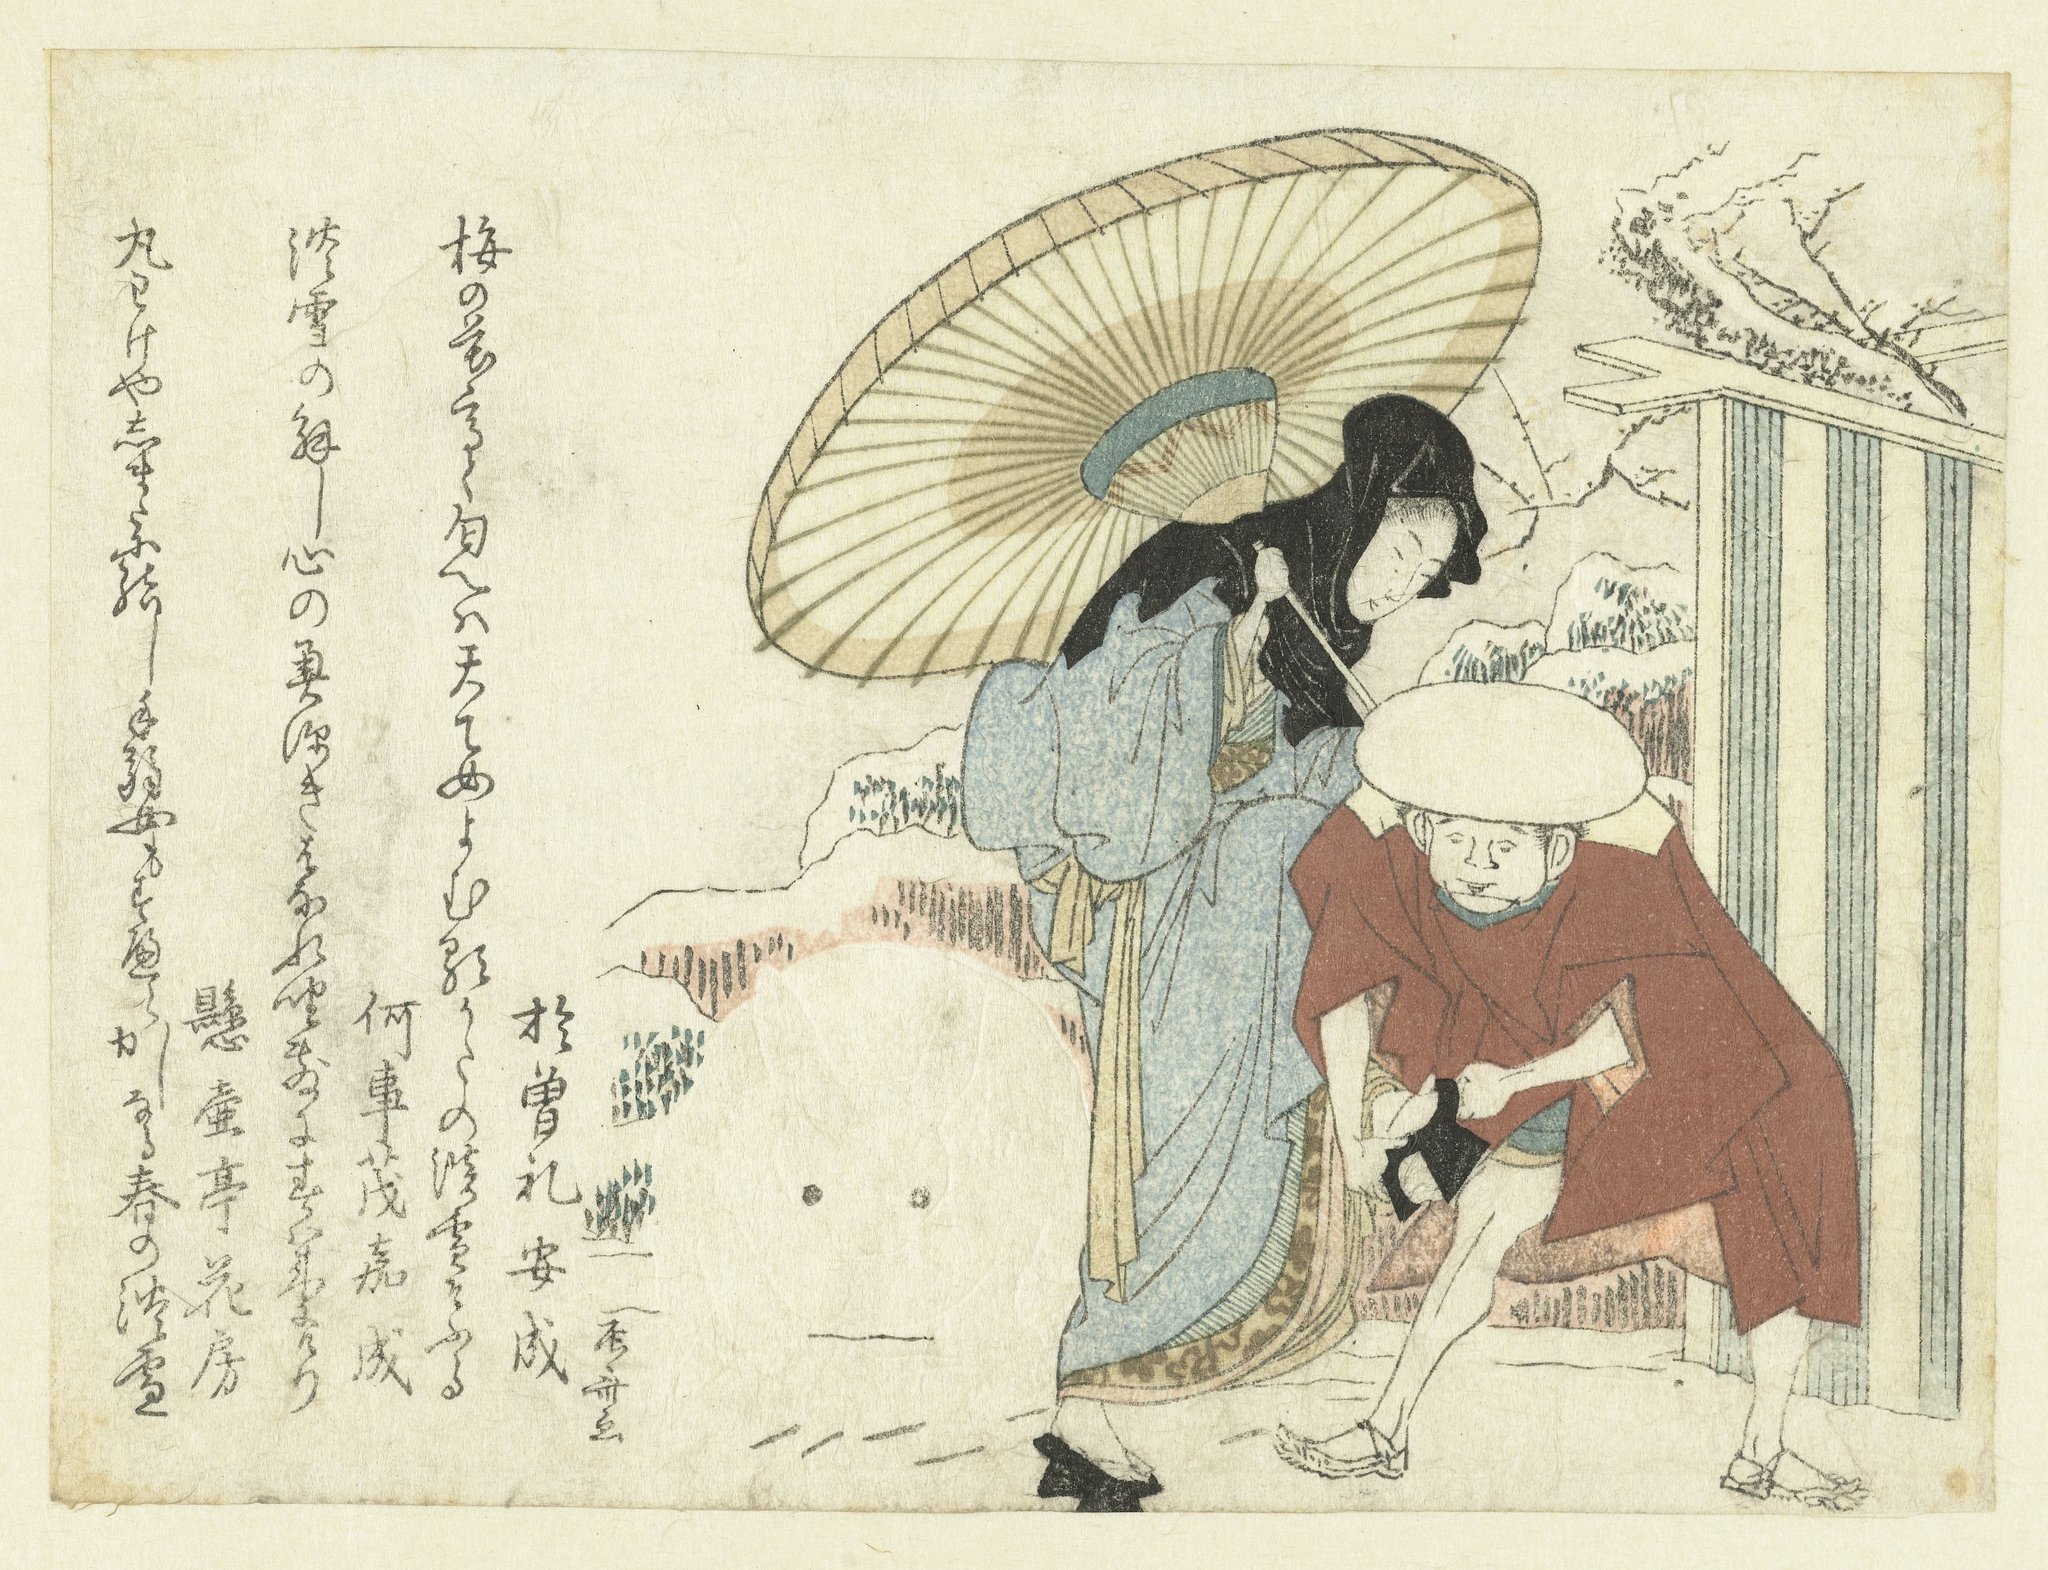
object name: surimono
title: Removing Clogged Snow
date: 1807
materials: paper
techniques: blind stamped, woodcut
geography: japan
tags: snow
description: Een surimono is een luxe uitgevoerde prent waarop beeld met één of meerdere gedichten gecombineerd is. Bij het drukken van een surimono werd vaak gebruik gemaakt van dikker papier, blinddruk en metaal pigmenten, zoals koper- en zilverpoeder. De prenten werden vaak in opdracht van dichters gemaakt en als exclusief geschenk aan vrienden en relaties gegeven.